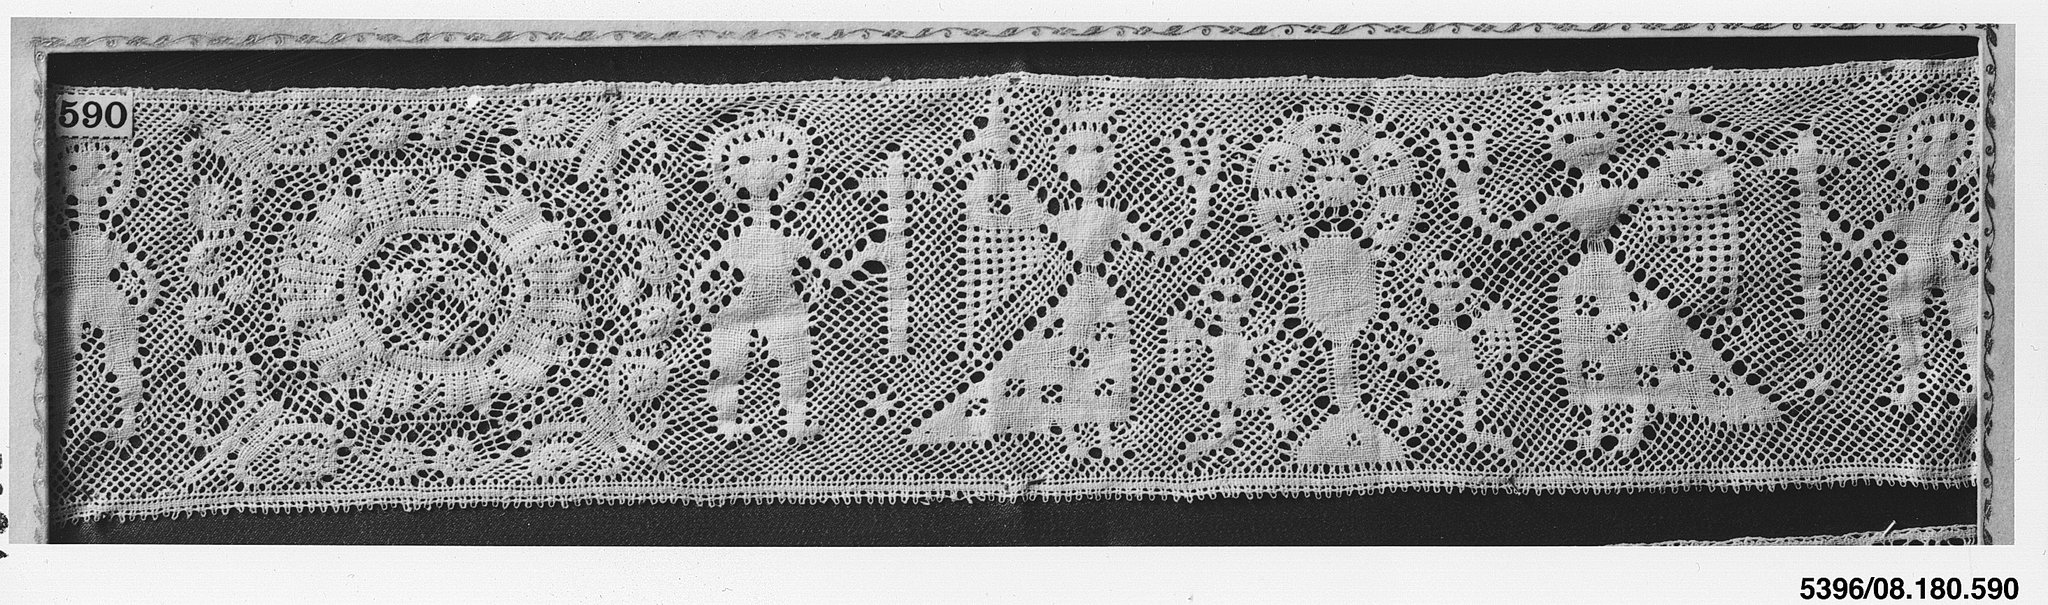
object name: fragment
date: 1601-1700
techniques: lace